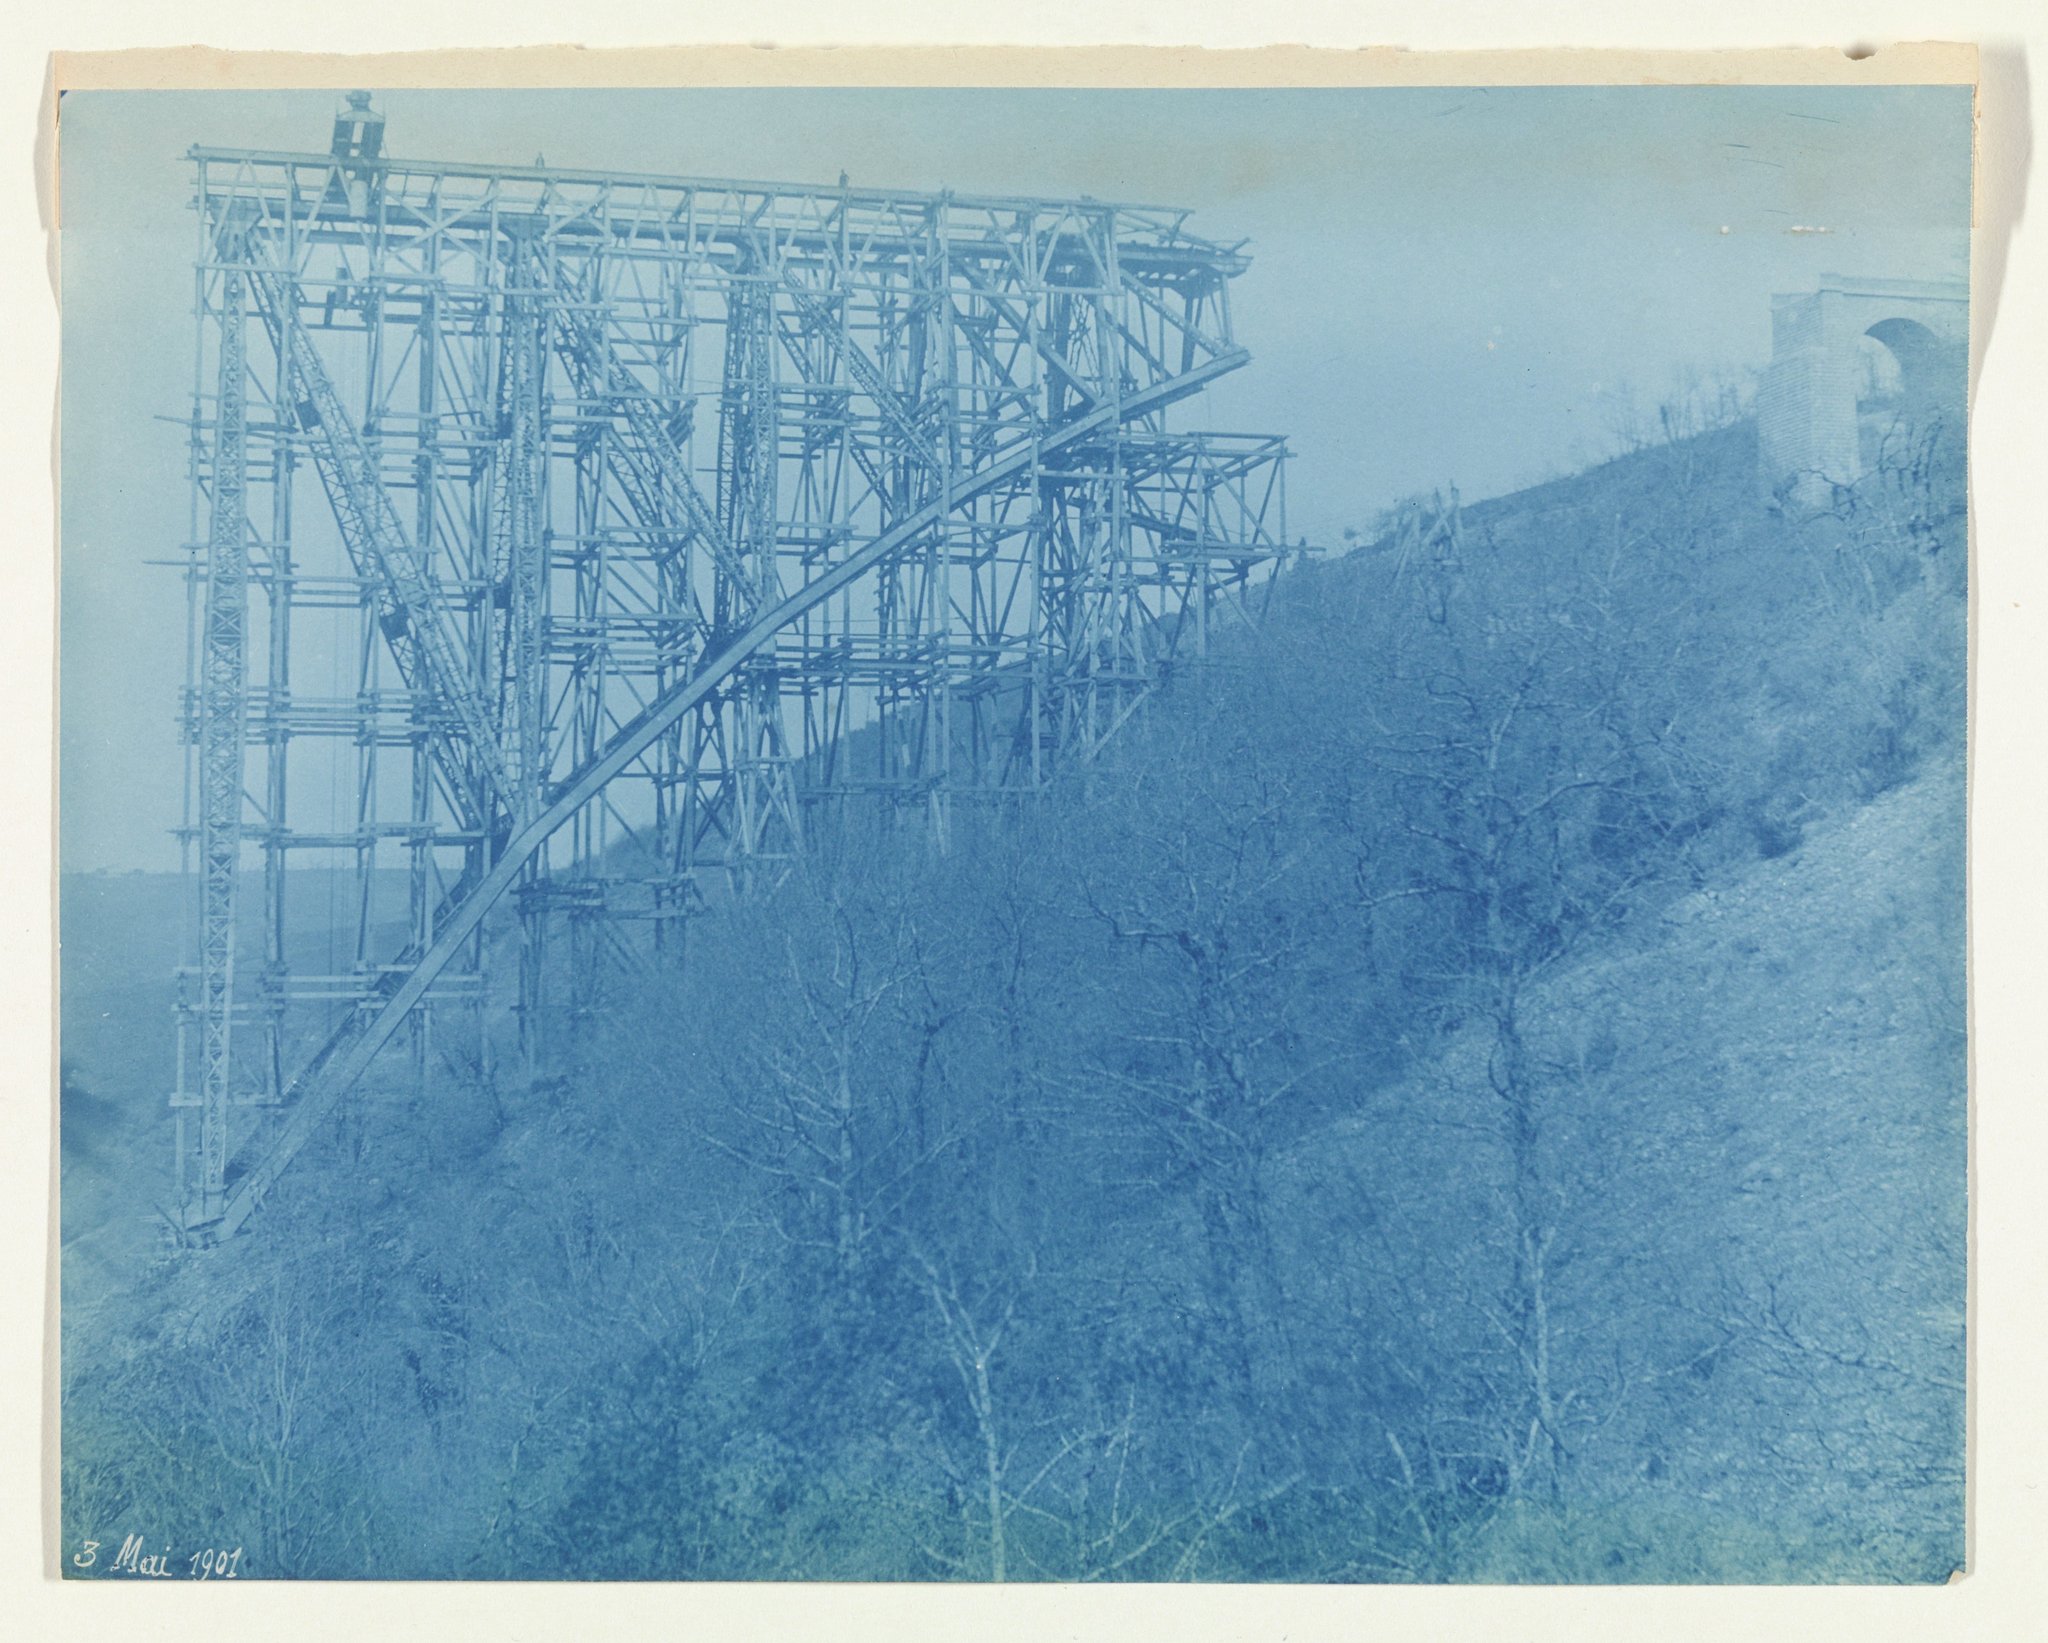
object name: photograph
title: Aanleg van het Viaur Viaduct in Frankrijk door de Societé de Construction des Battignolles, 3 mei 1901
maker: Anonymous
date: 1901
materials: photographic support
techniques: cyanotype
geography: france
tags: viaduct, making the overground structures (~ building activities)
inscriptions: date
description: Met potloodschets (van een technische constructie?) achterop.